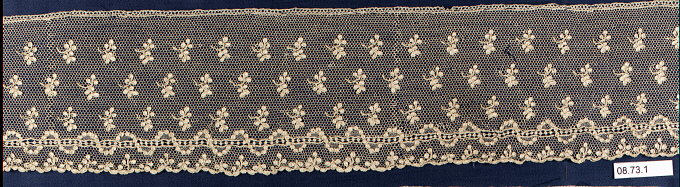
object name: fragment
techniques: lace